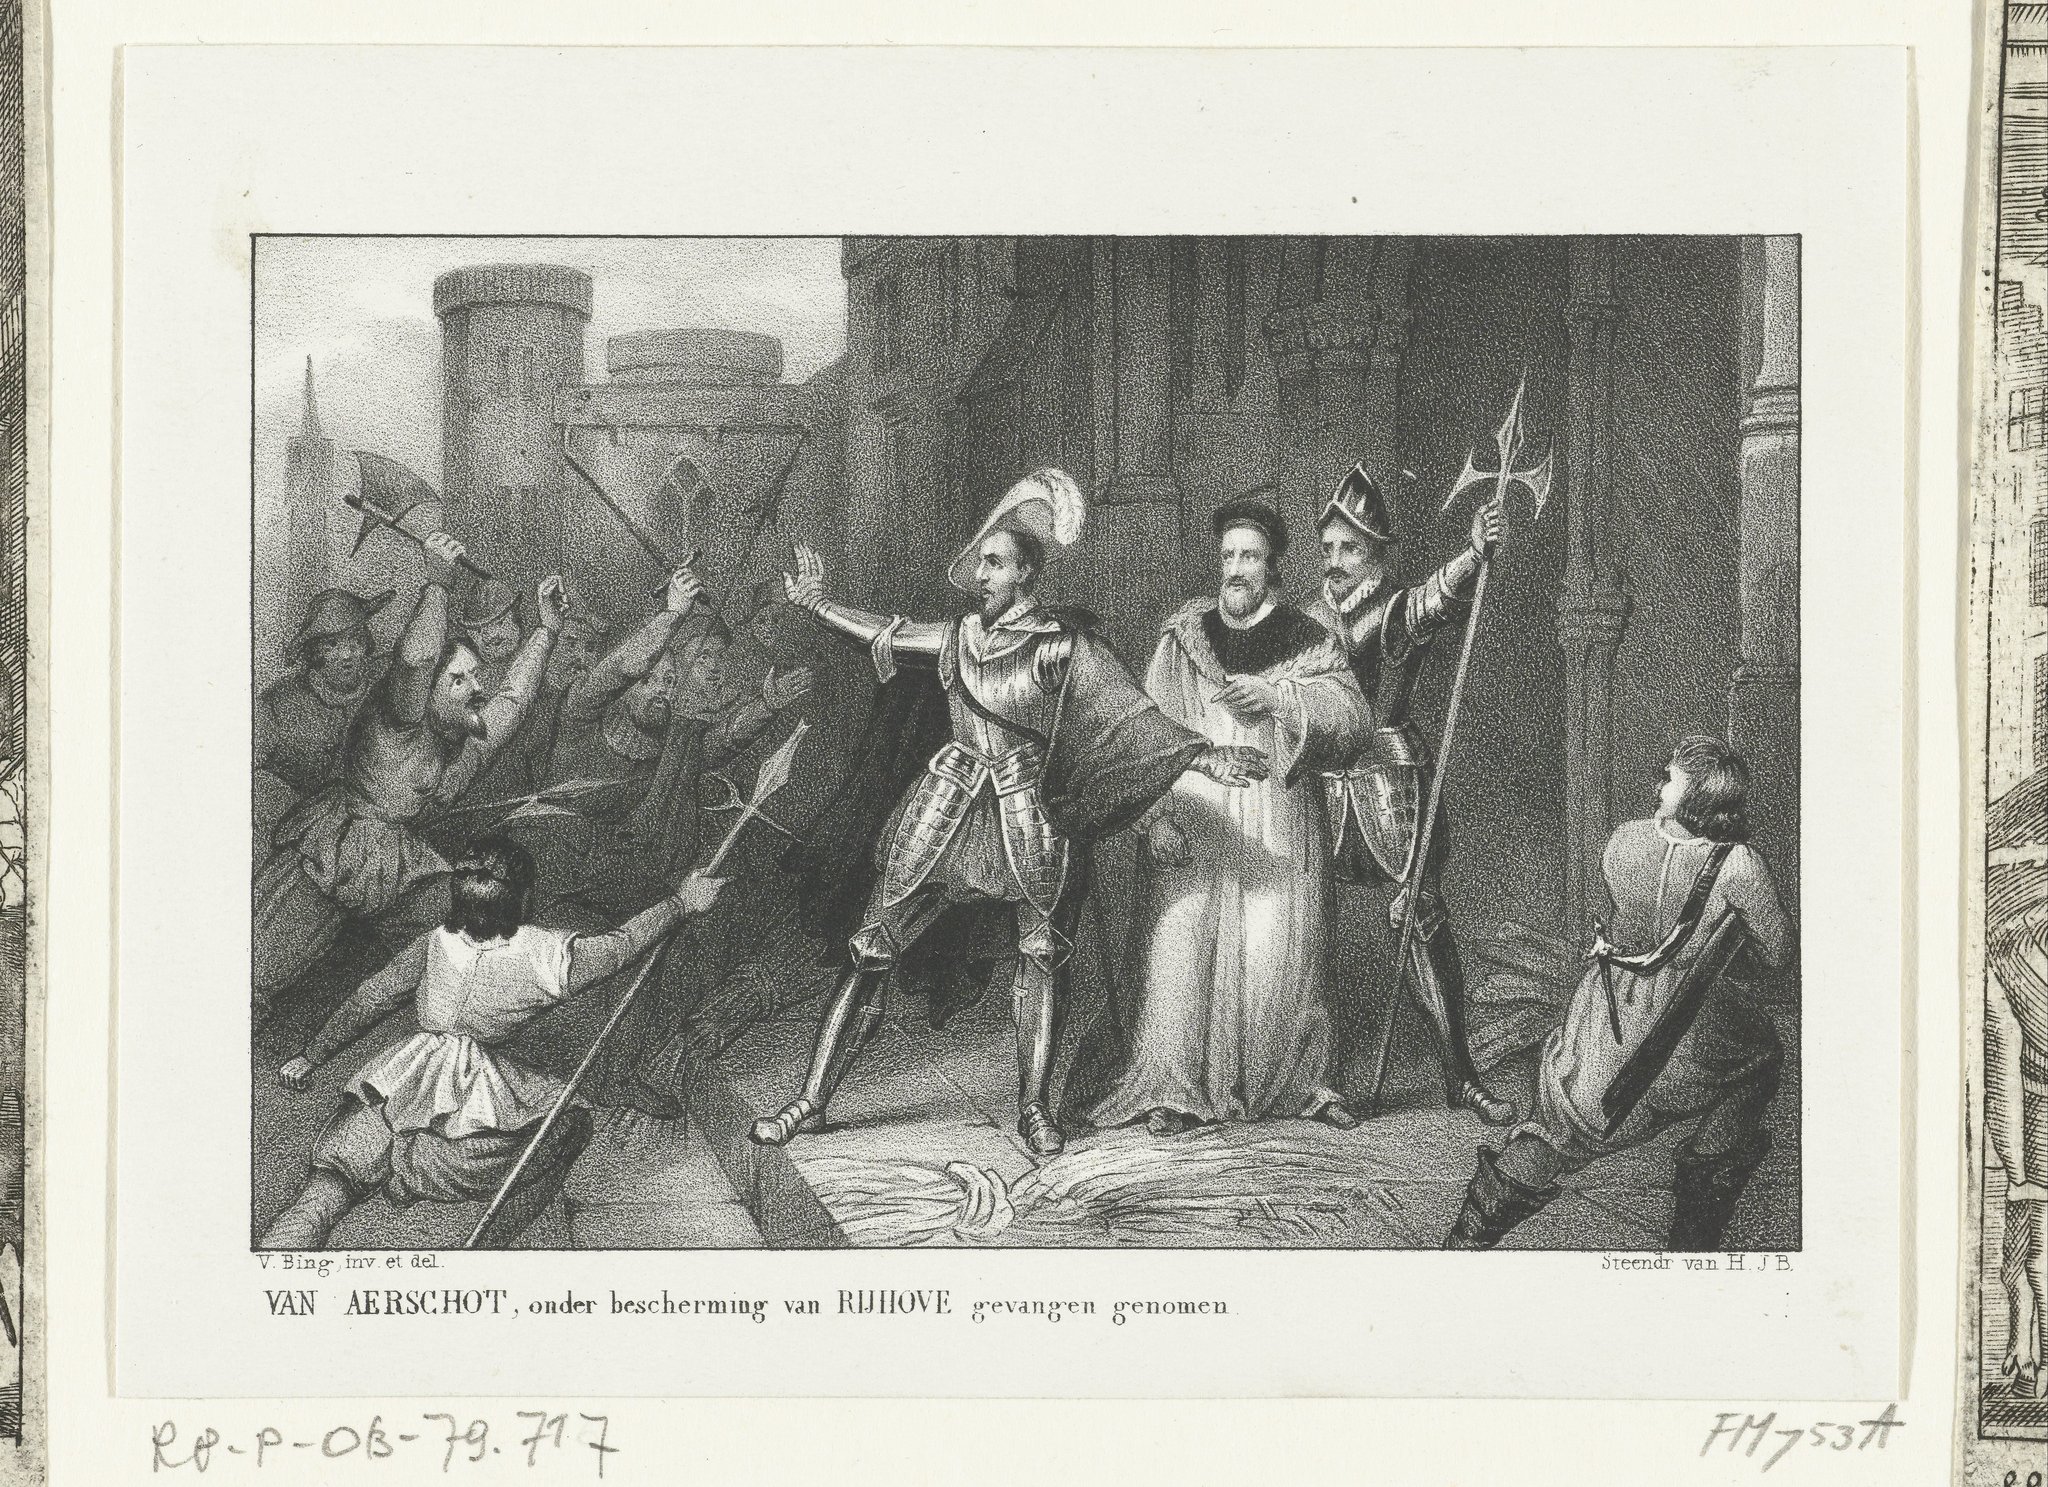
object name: history print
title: Van Aerschot, onder bescherming van Rijhove gevangen genomen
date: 1822-1845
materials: paper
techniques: lithograph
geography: netherlands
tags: utrecht, earl, imprisonment, ghent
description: De gevangenneming van de hertog van Aarschot te Gent, 28 oktober 1577. De hertog wordt beschermd tegen de woedende menigte door François van Ryhove.